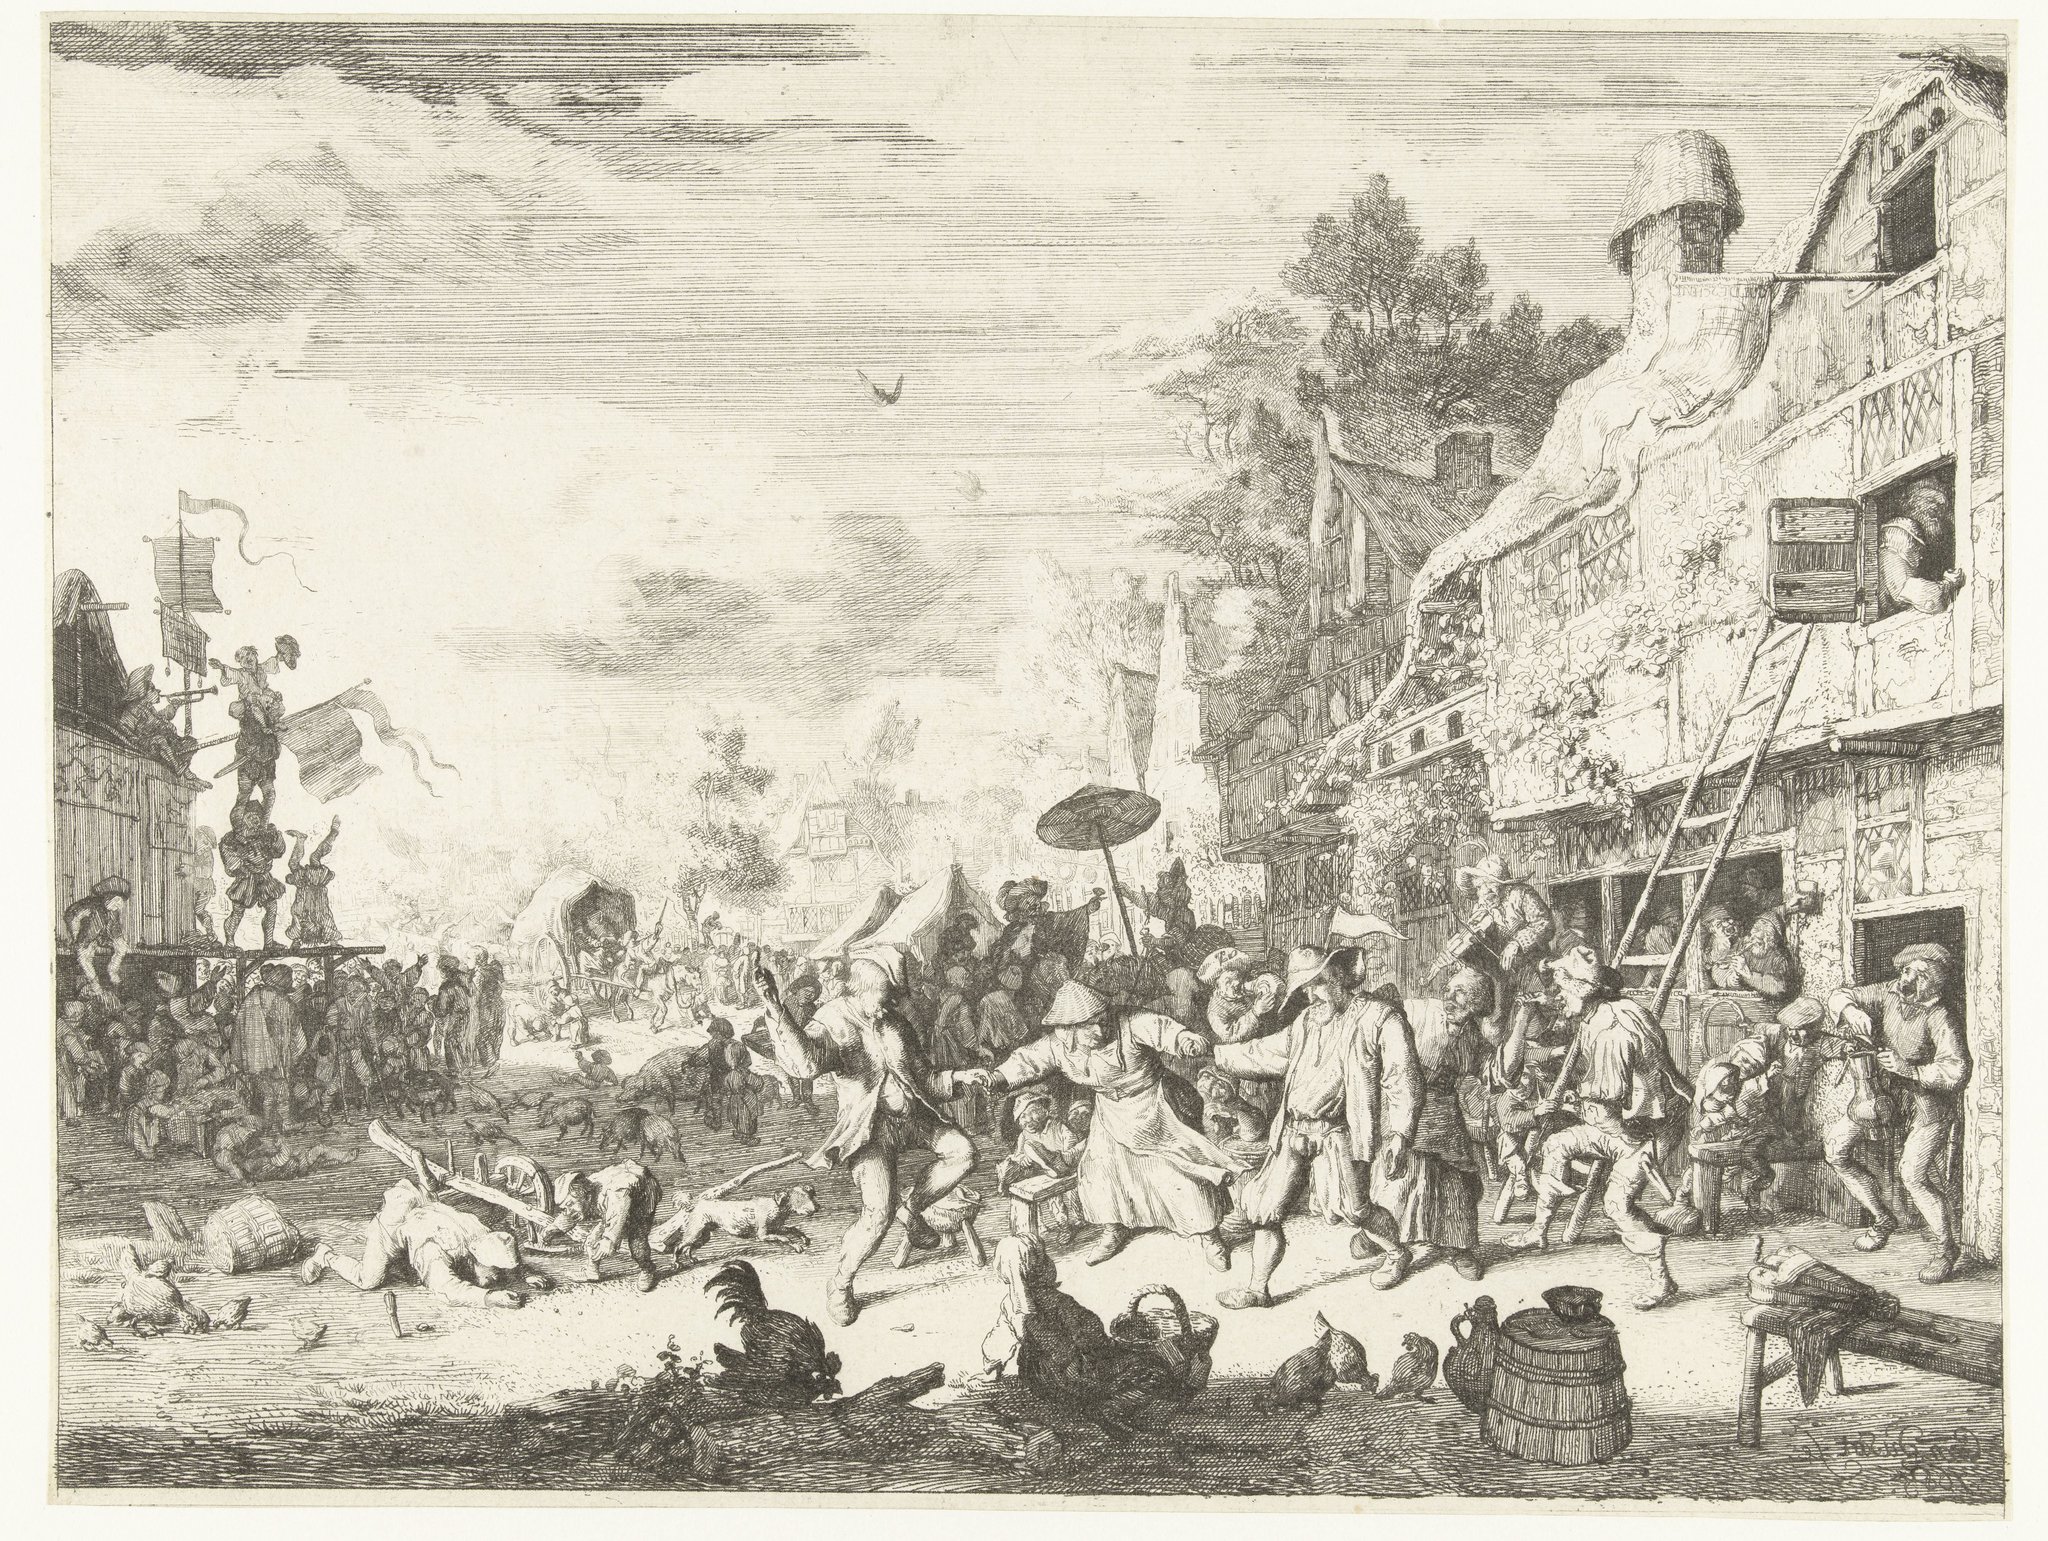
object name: print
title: Grote dorpskermis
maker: cornelis dusart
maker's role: draughtsman, painter, print maker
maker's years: 1660-1704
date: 1685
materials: paper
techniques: printmaking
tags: performance in the open air (pleasure fair)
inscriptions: collector's mark: Lugt 2228a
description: Tegenafdruk van de grote prent de dorpskermis. In een dorpsstraat wordt gedanst en muziek gemaakt voor een herberg waar de drank rijkelijk vloeit. Acrobaten vertonen hun kunsten op een podium en varkens en kippen scharrelen op zoek naar voedsel tussen de feestende dorpsbewoners.